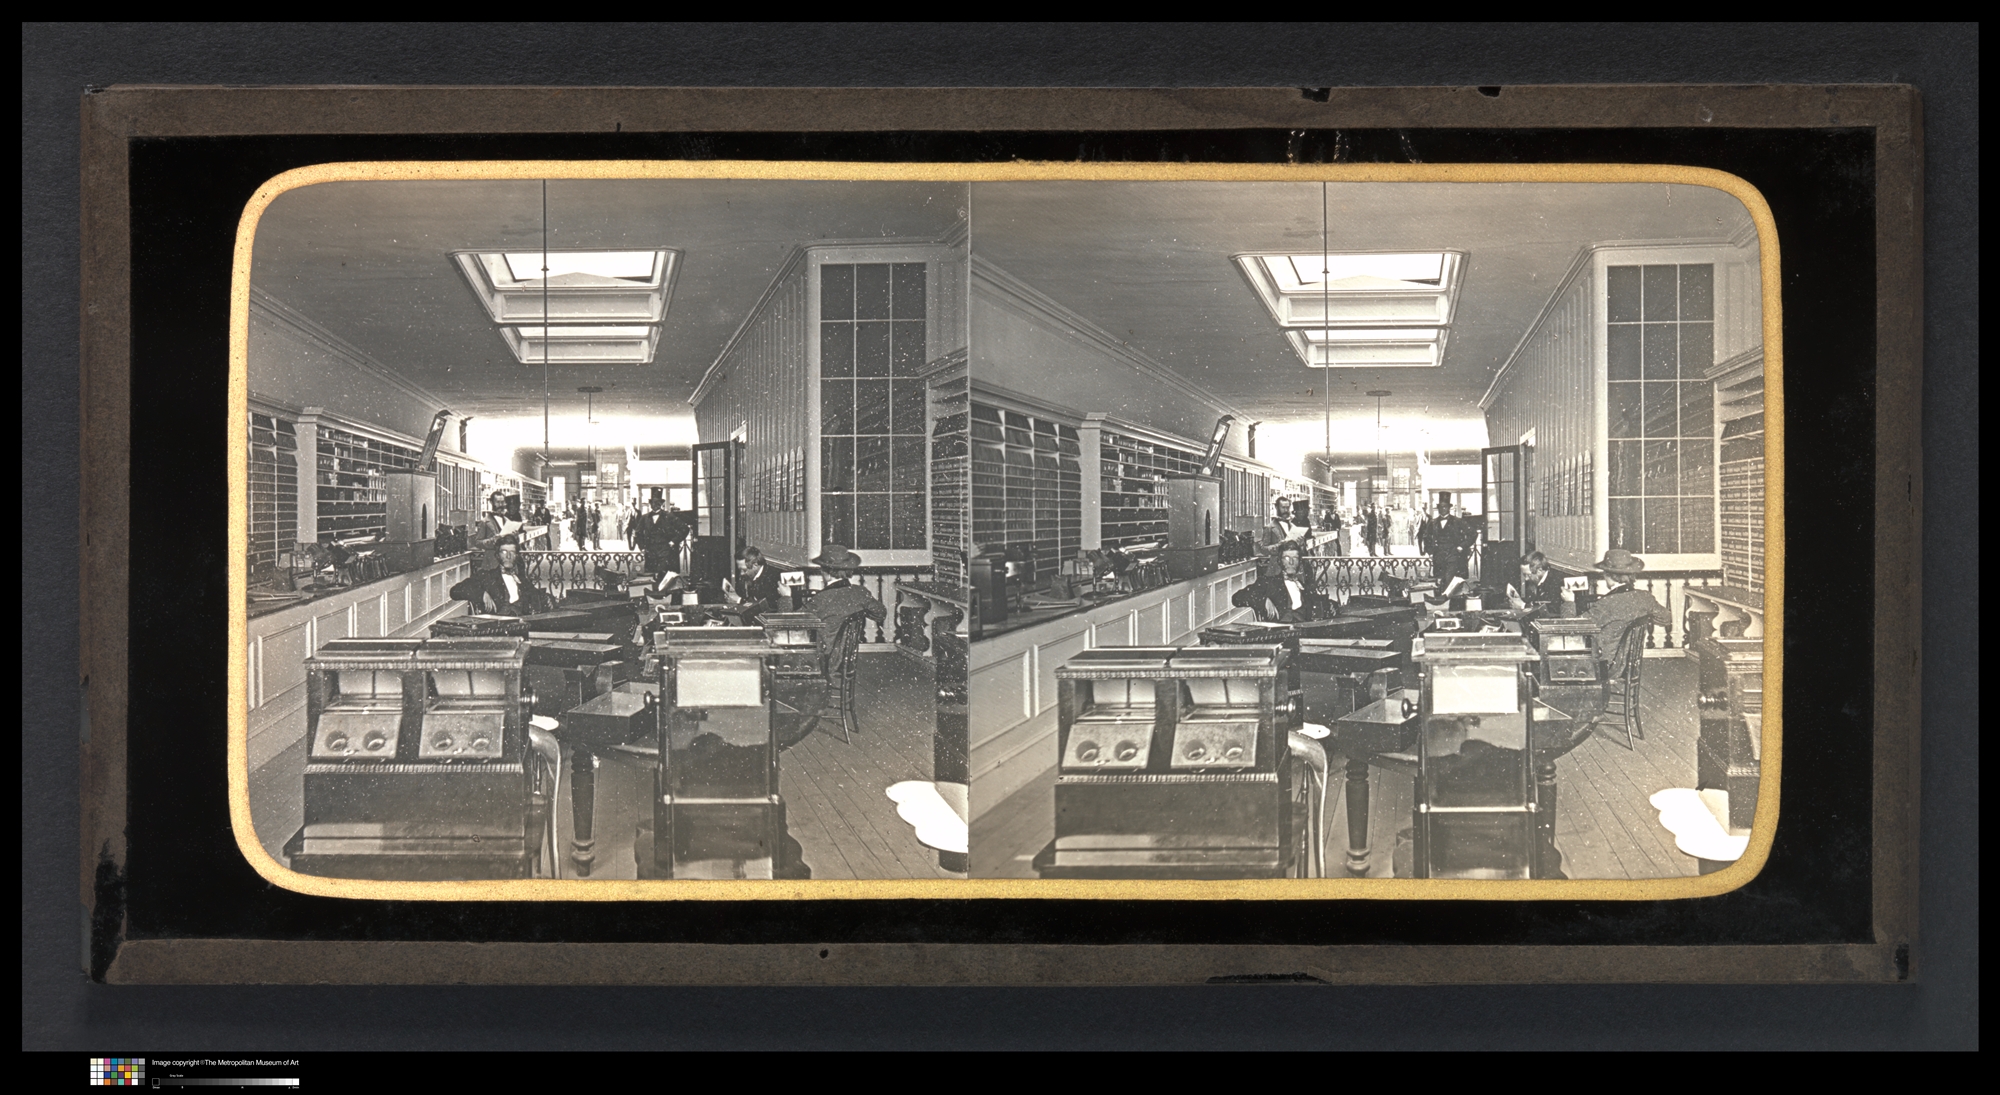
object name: stereograph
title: [29 Glass Stereographs]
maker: various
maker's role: artist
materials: glass